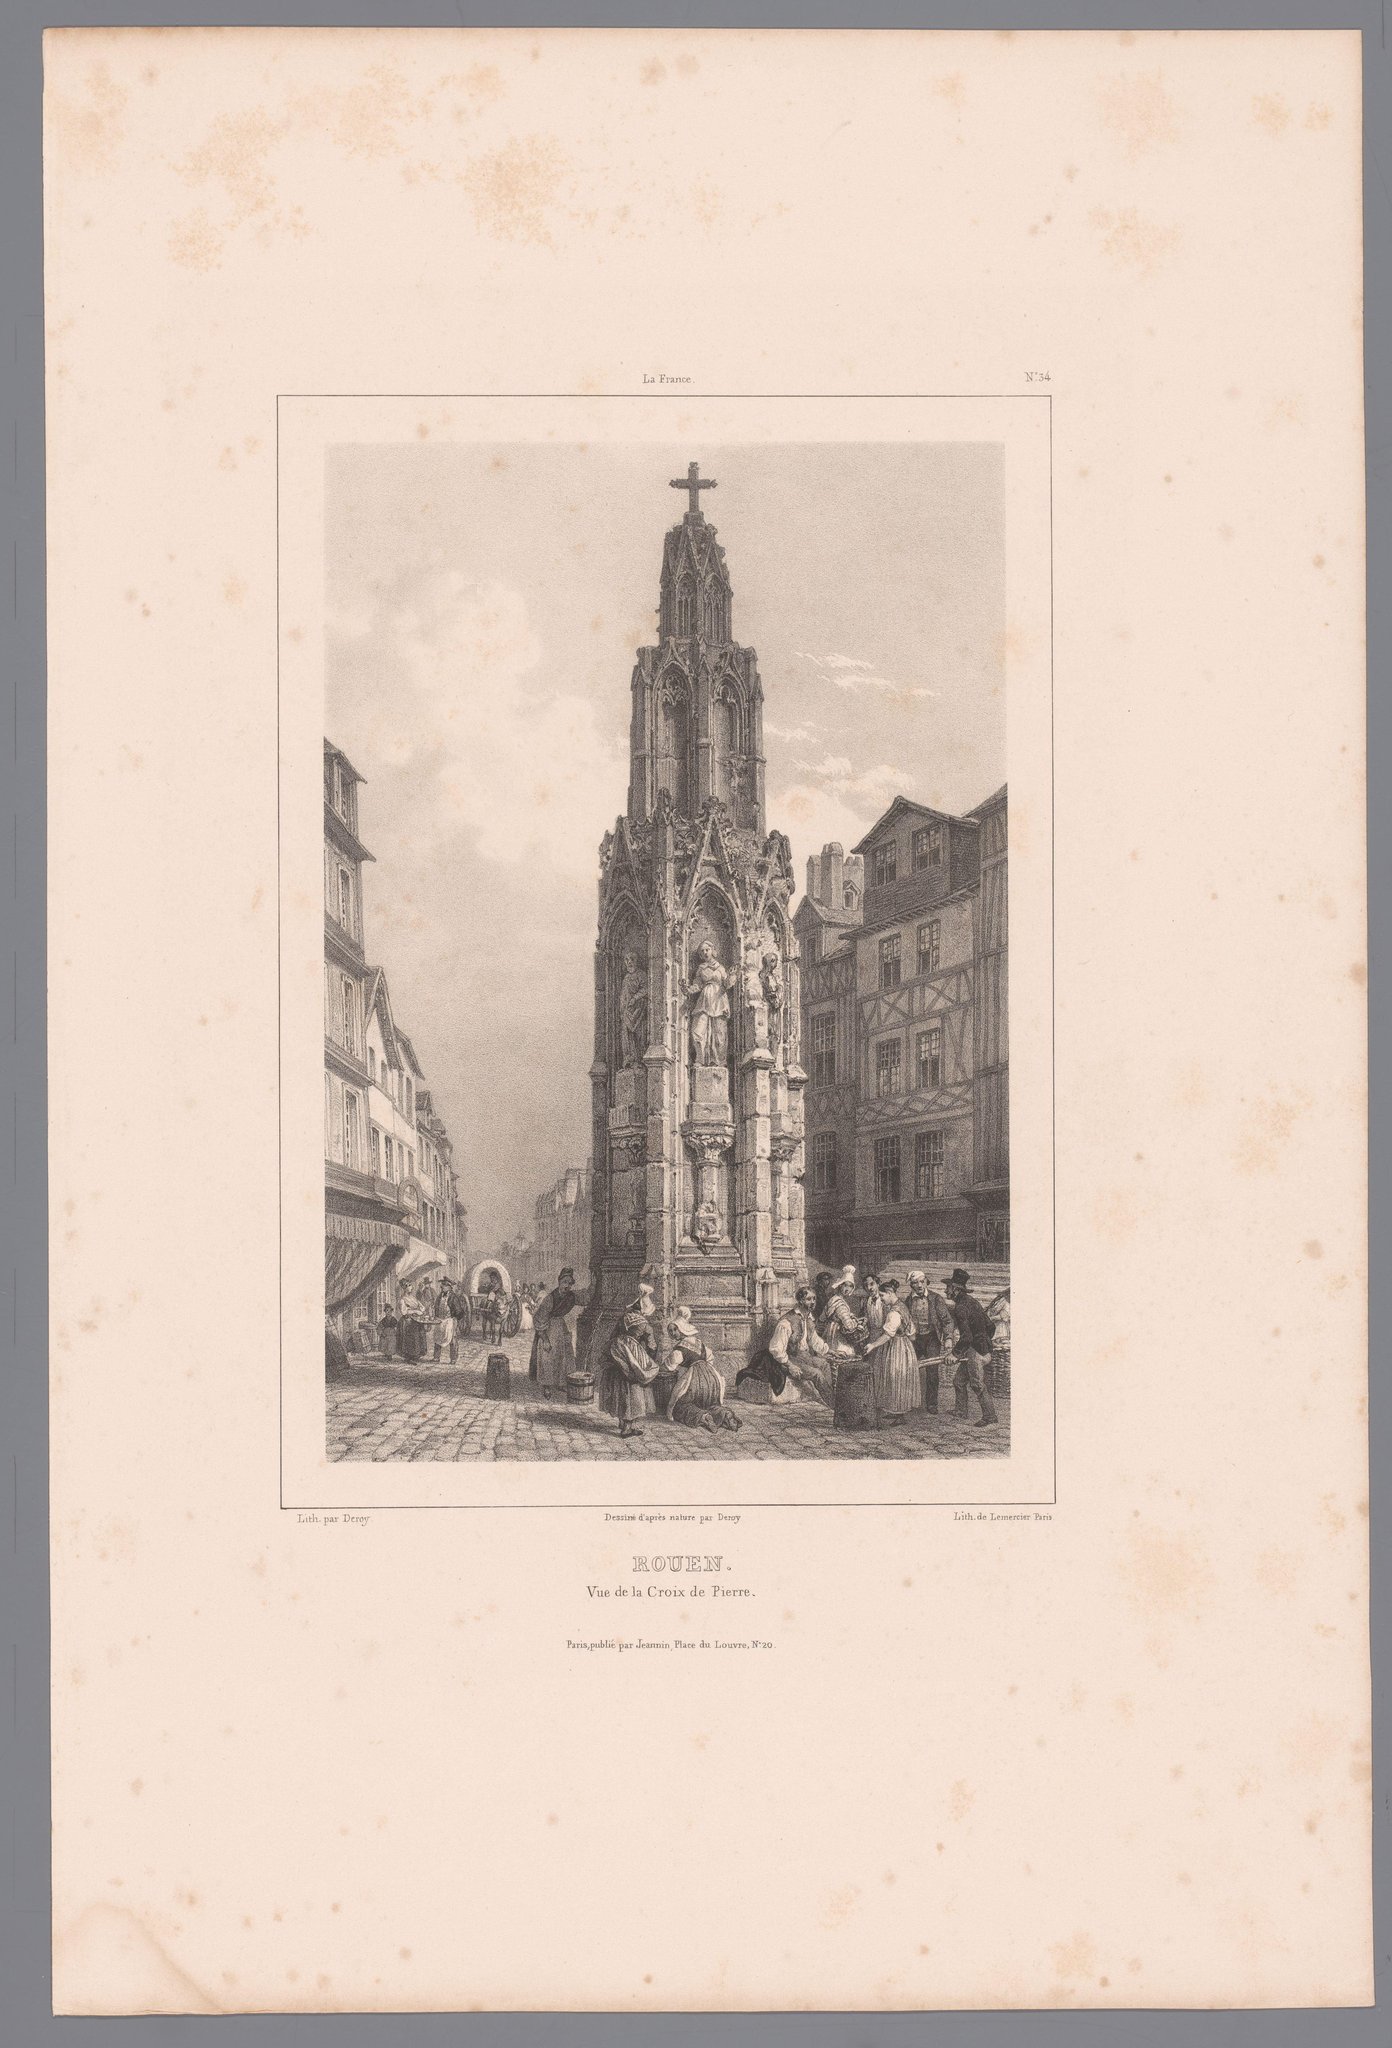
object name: print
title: Zicht op de fontaine de la Croix-de-Pierre te Rouen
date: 1834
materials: paper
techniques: lithograph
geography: paris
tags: ornamental fountain (+ city(-scape) with figures, staffage)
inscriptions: collector's mark: Lugt 2228a